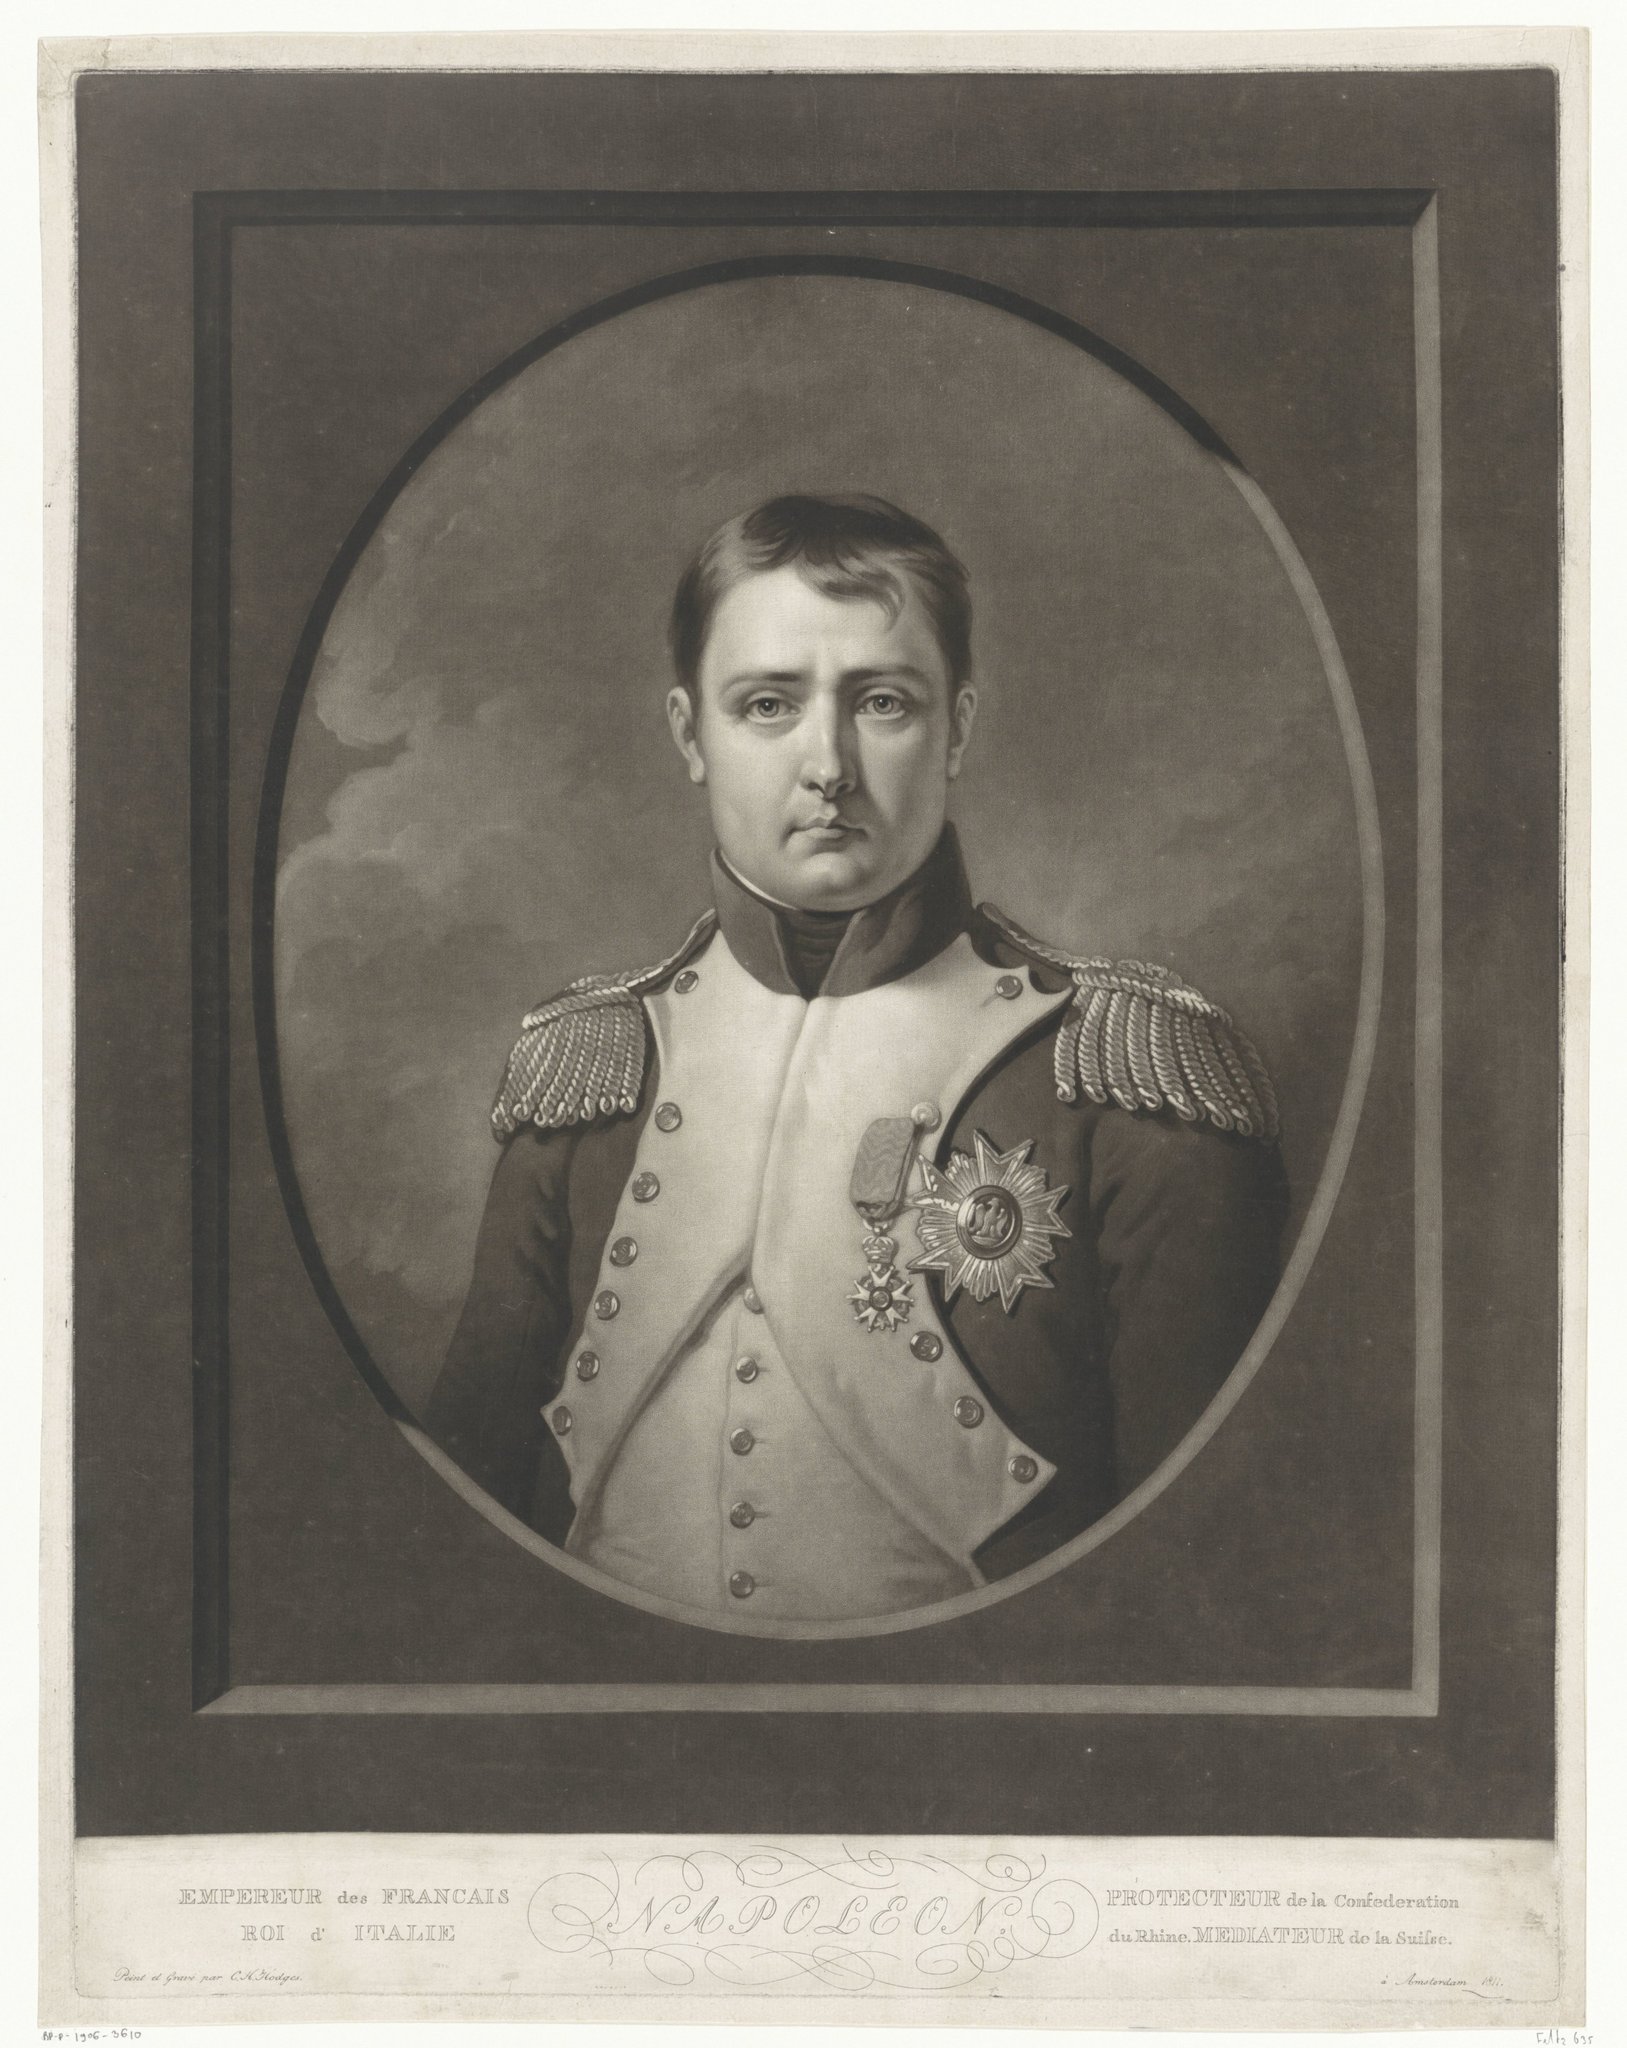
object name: print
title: Portret van Napoleon I Bonaparte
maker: charles howard hodges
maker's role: draughtsman, painter, print maker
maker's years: 1764-1837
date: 1811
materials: paper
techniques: mezzotint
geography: amsterdam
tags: napoleon i (emperor of the french)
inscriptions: collector's mark: Lugt 2228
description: Portretbuste van Napoleon I Bonaparte, keizer der Fransen. Hij is gekleed in een uniform met epauletten.